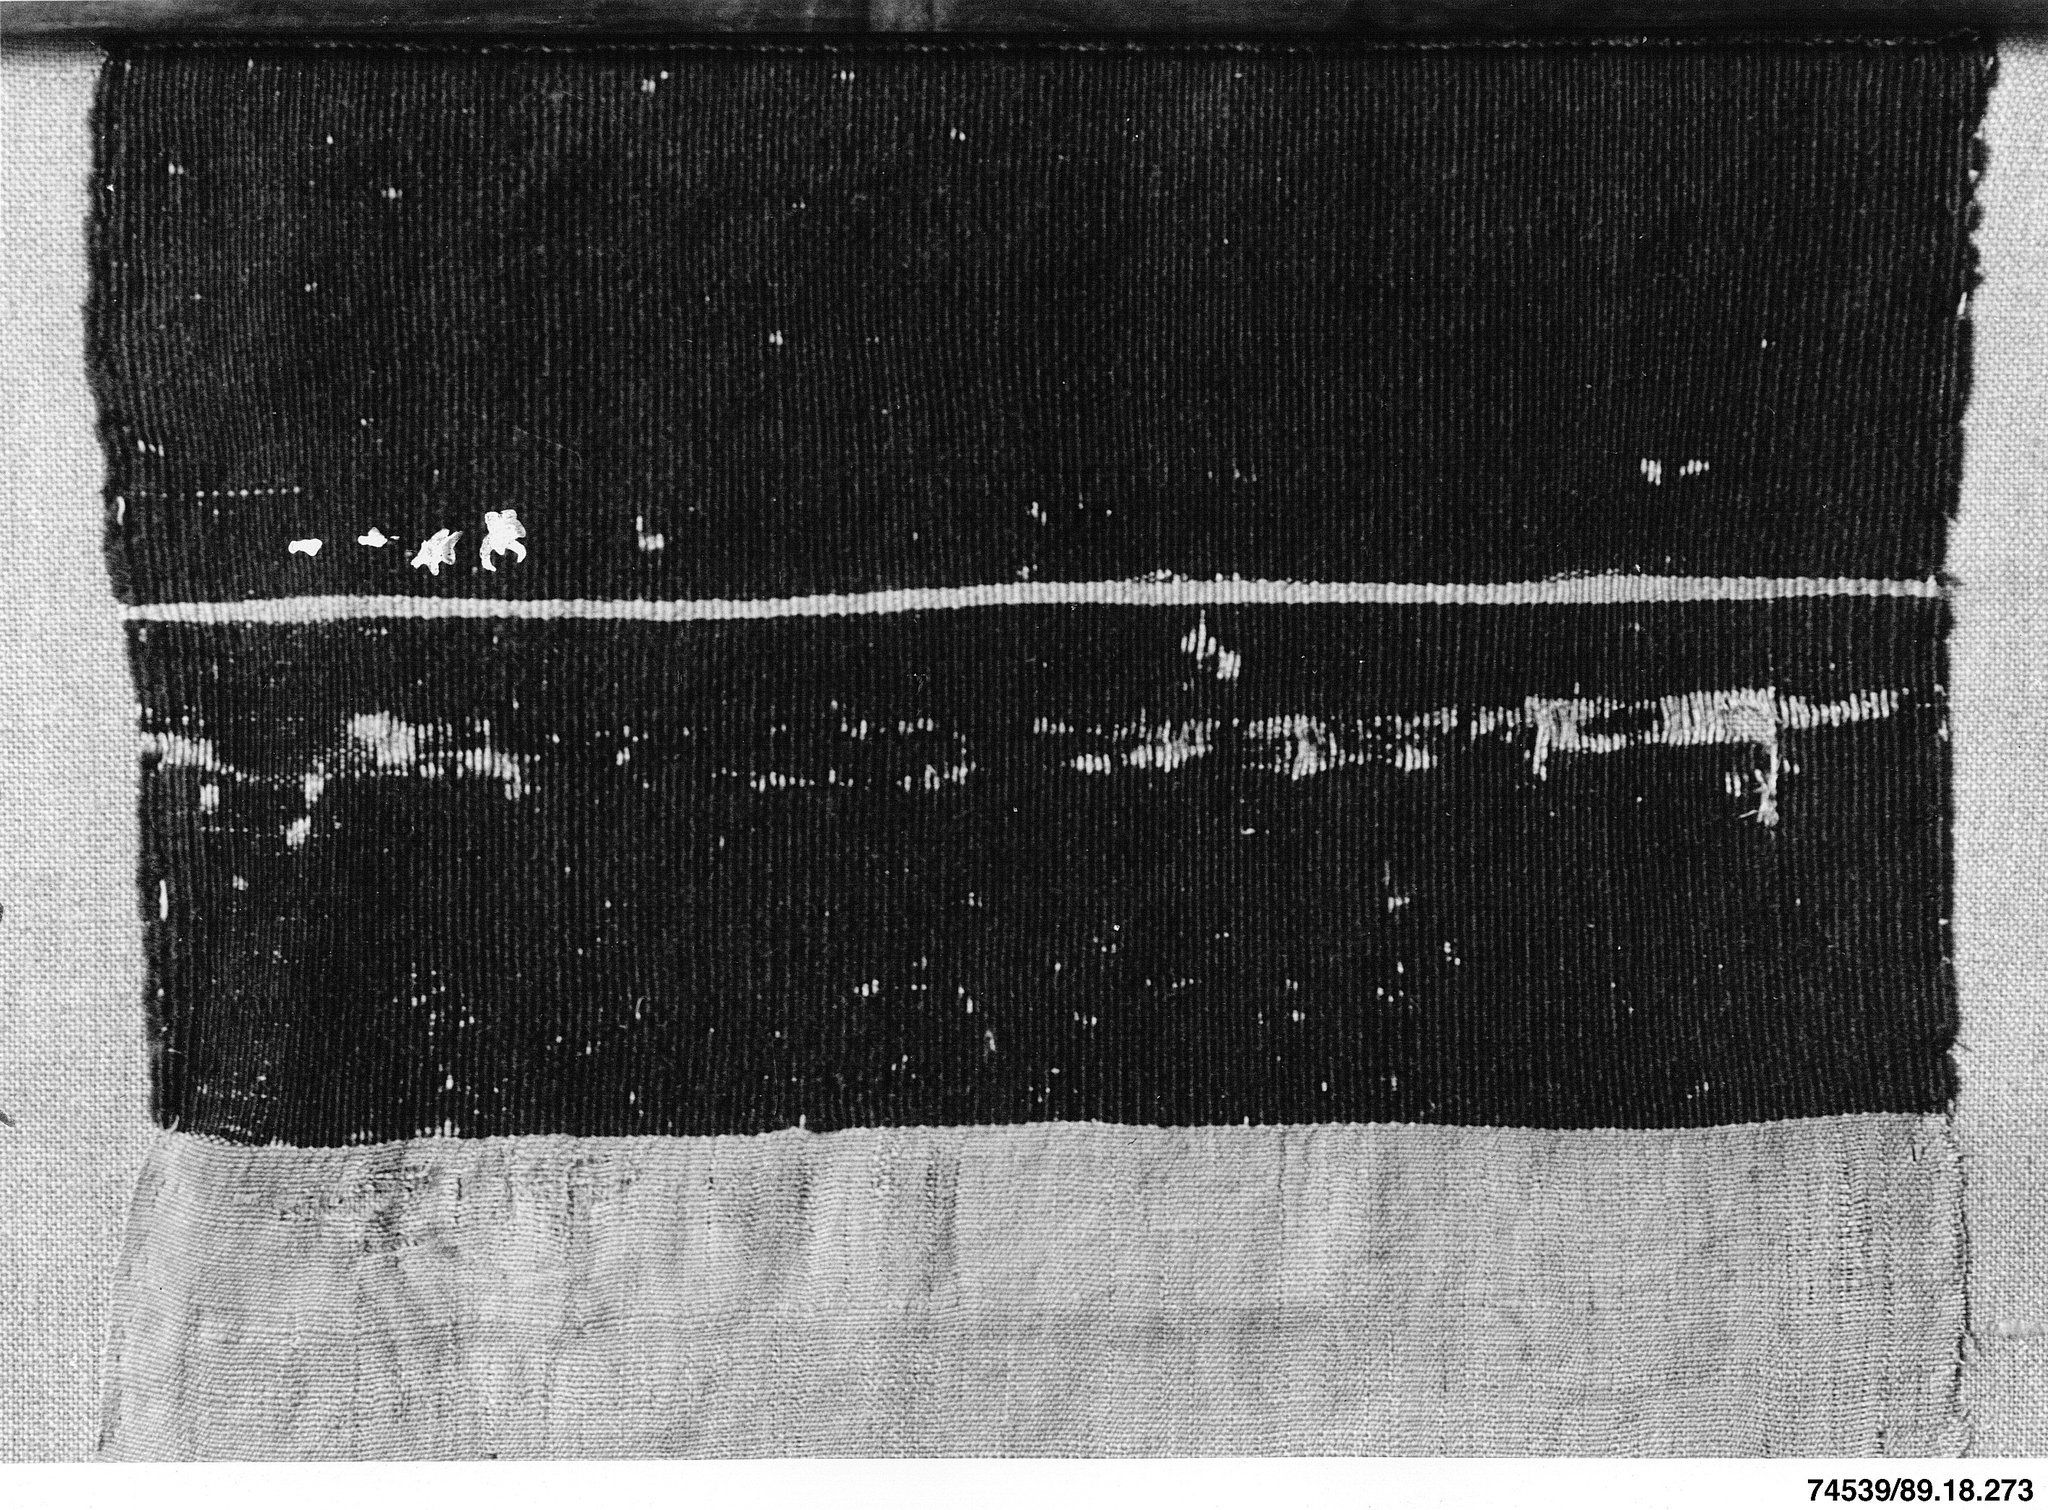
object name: textile fragment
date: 201-400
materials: linen, wool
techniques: weave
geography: egypt